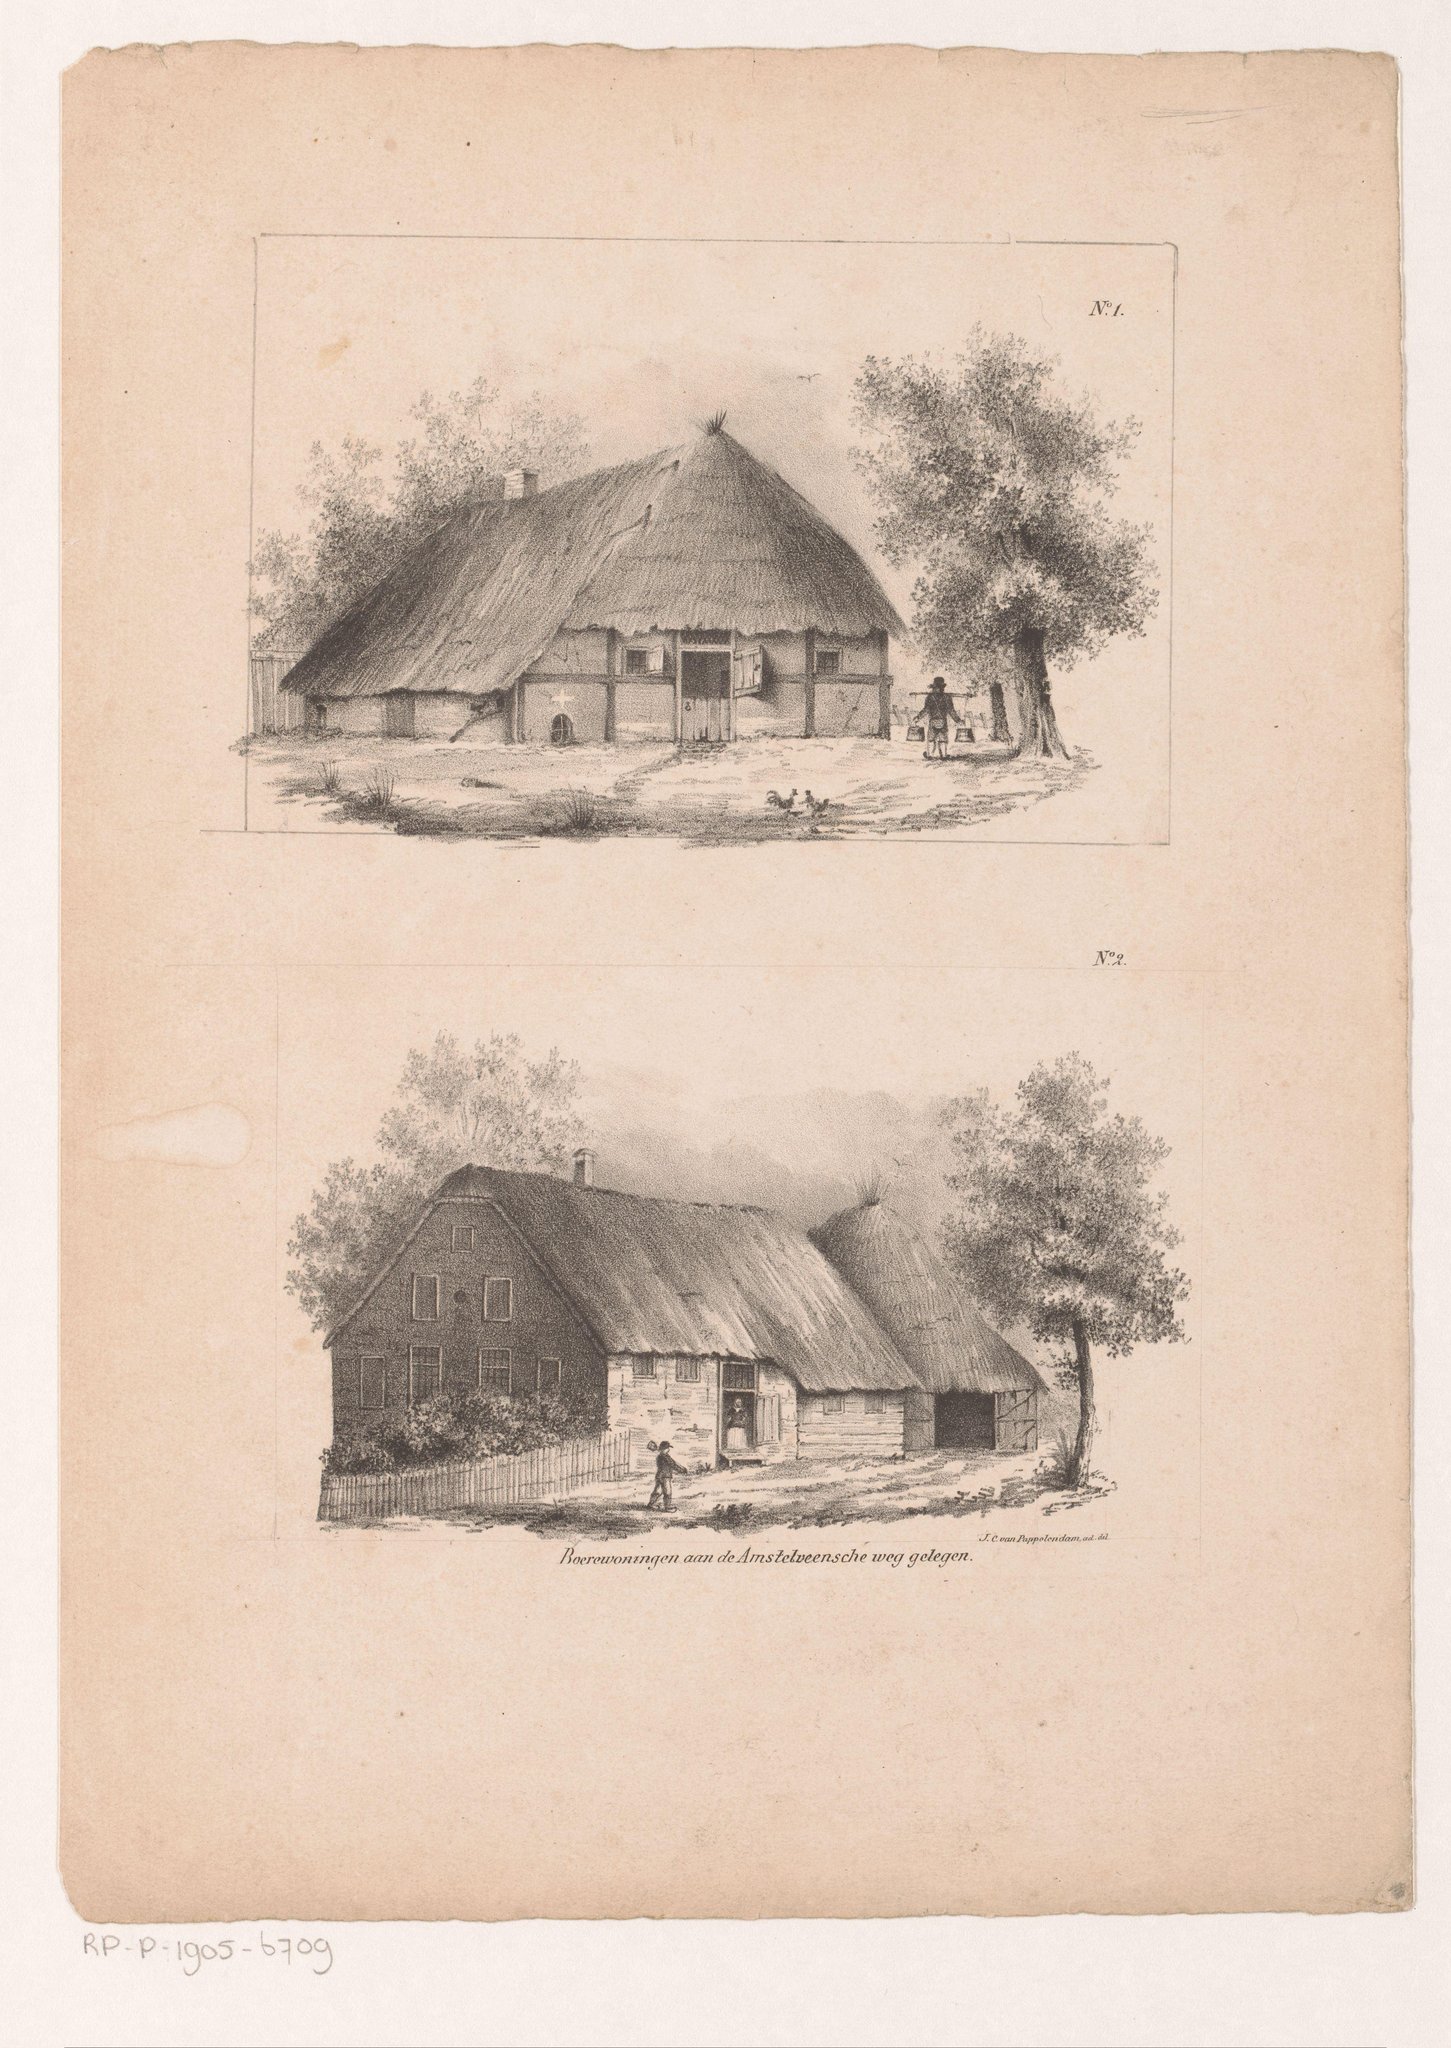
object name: print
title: Twee boerenwoningen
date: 1825-1845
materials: paper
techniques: lithograph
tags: farm or solitary house in landscape, amsterdam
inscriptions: collector's mark: Lugt 2228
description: Gezichten op twee boerenwoningen aan de Amstelveenseweg.